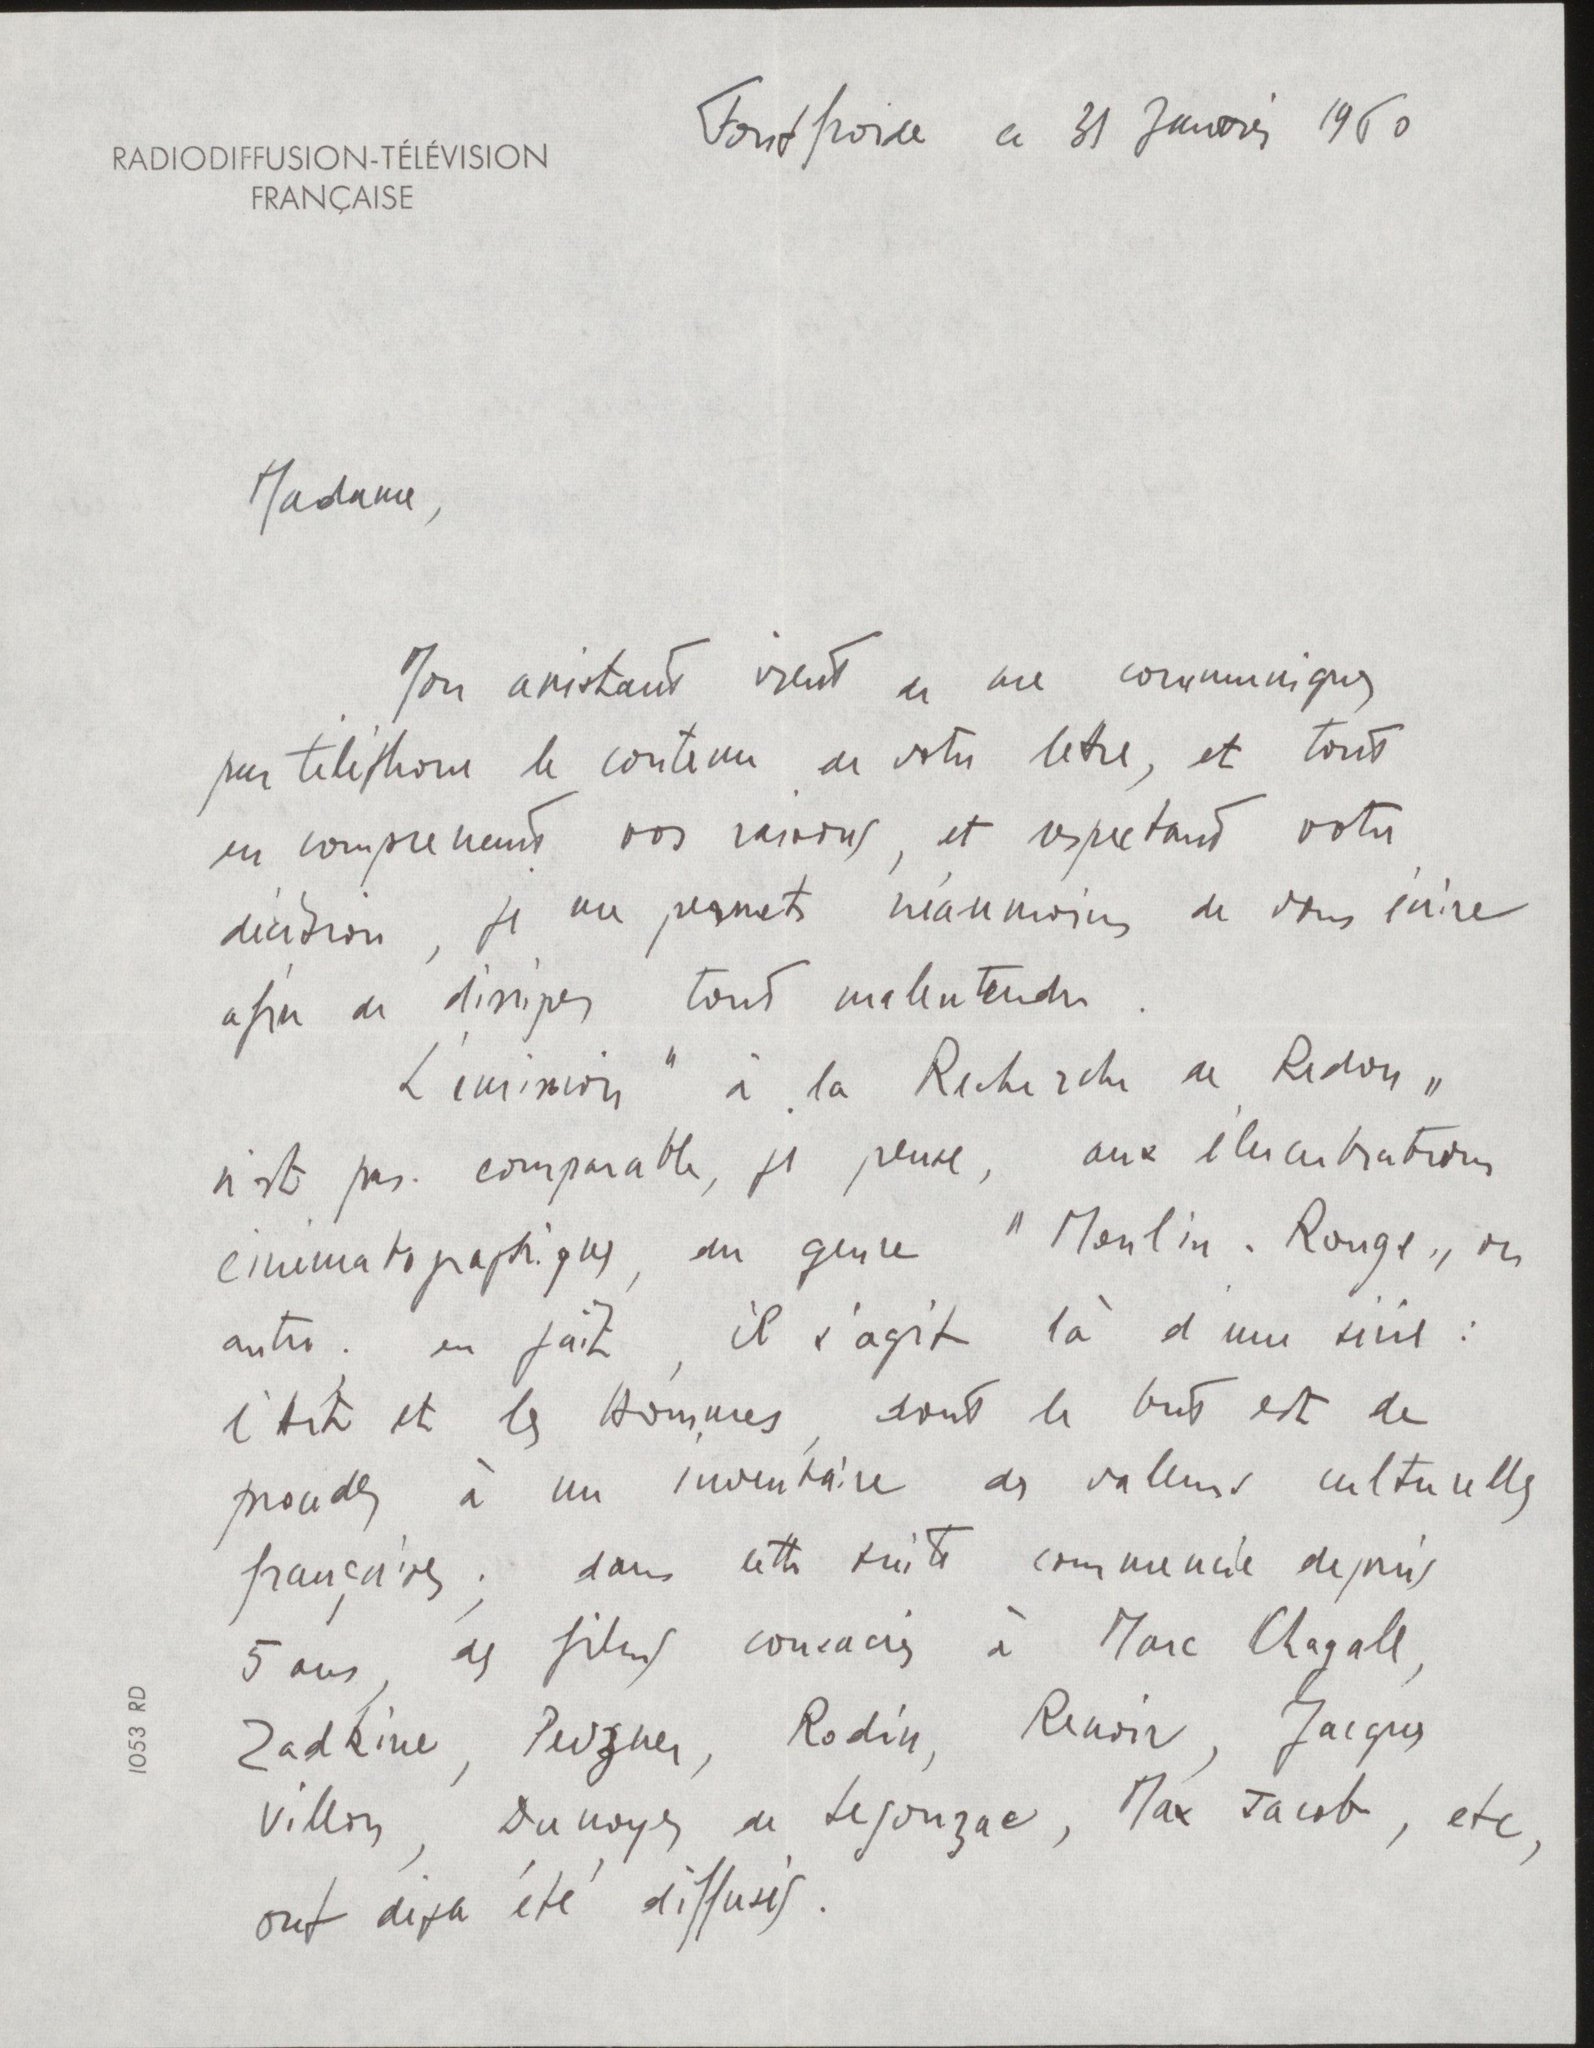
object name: letter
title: Brief aan Françoise W.M. Bonger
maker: Anonymous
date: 1960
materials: ink, paper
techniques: pen, printing, writing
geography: france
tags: roseline bacou, paris, painter, print maker, draughtsman, odilon redon, françoise w.m. bonger